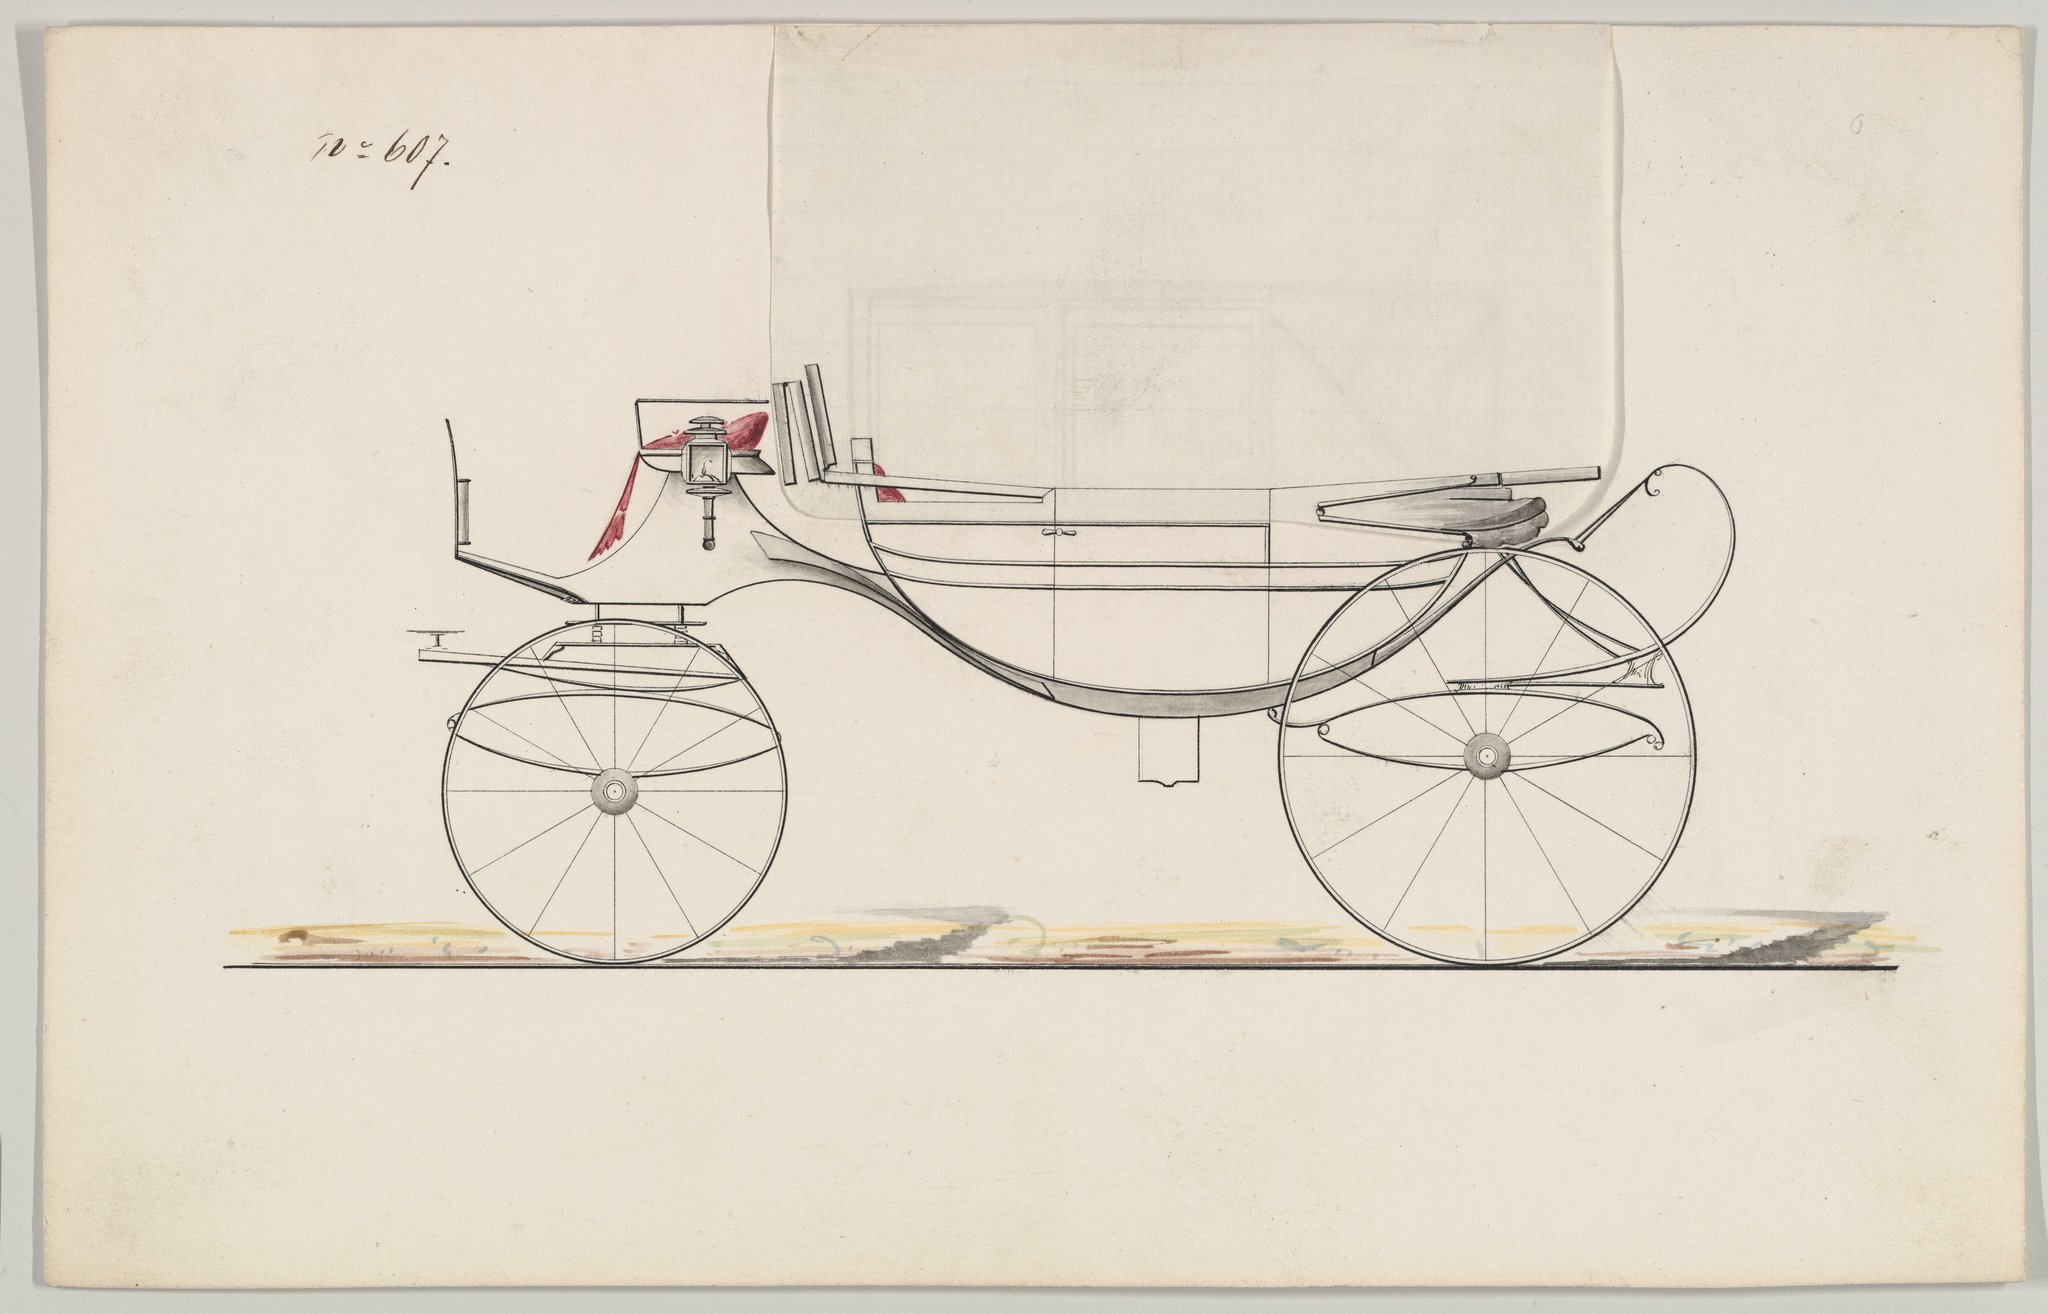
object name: drawing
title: Landau #607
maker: brewster & co.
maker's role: manufacturer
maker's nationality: american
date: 1851-1900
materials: ink, watercolor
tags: carriages